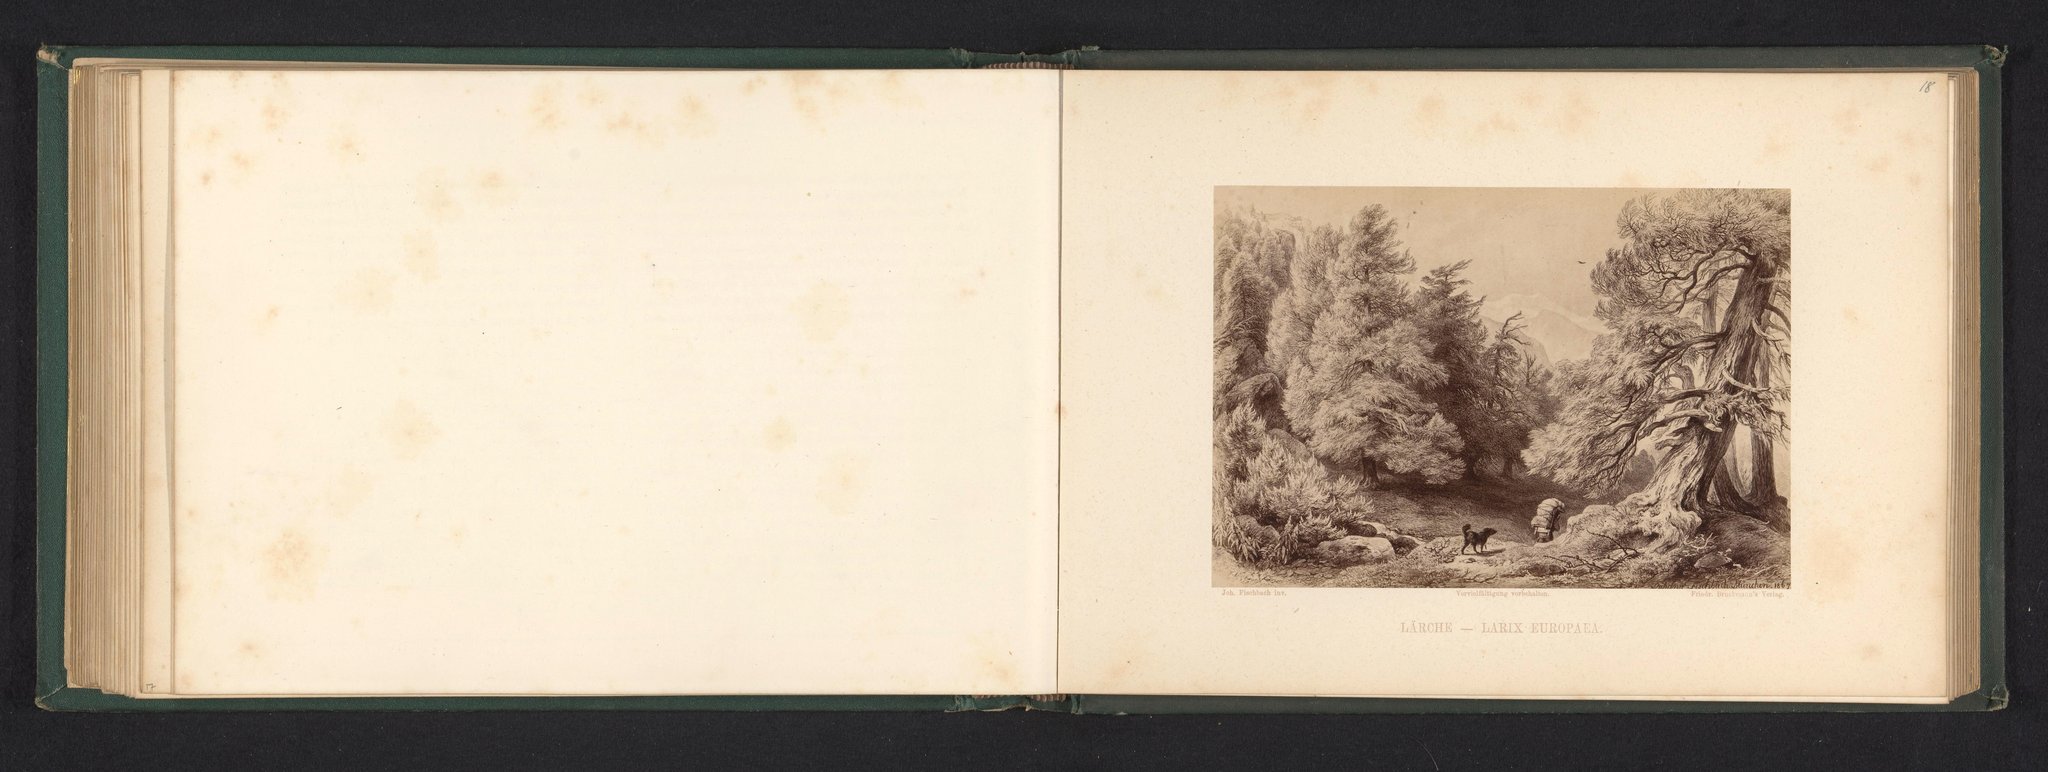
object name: photograph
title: Fotoreproductie van een tekening van een landschap met lariksen en een wandelaar met een hond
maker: johann fischbach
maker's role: painter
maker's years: 1797-1871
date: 1867-1879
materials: photographic support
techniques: albumen print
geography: munich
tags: trees